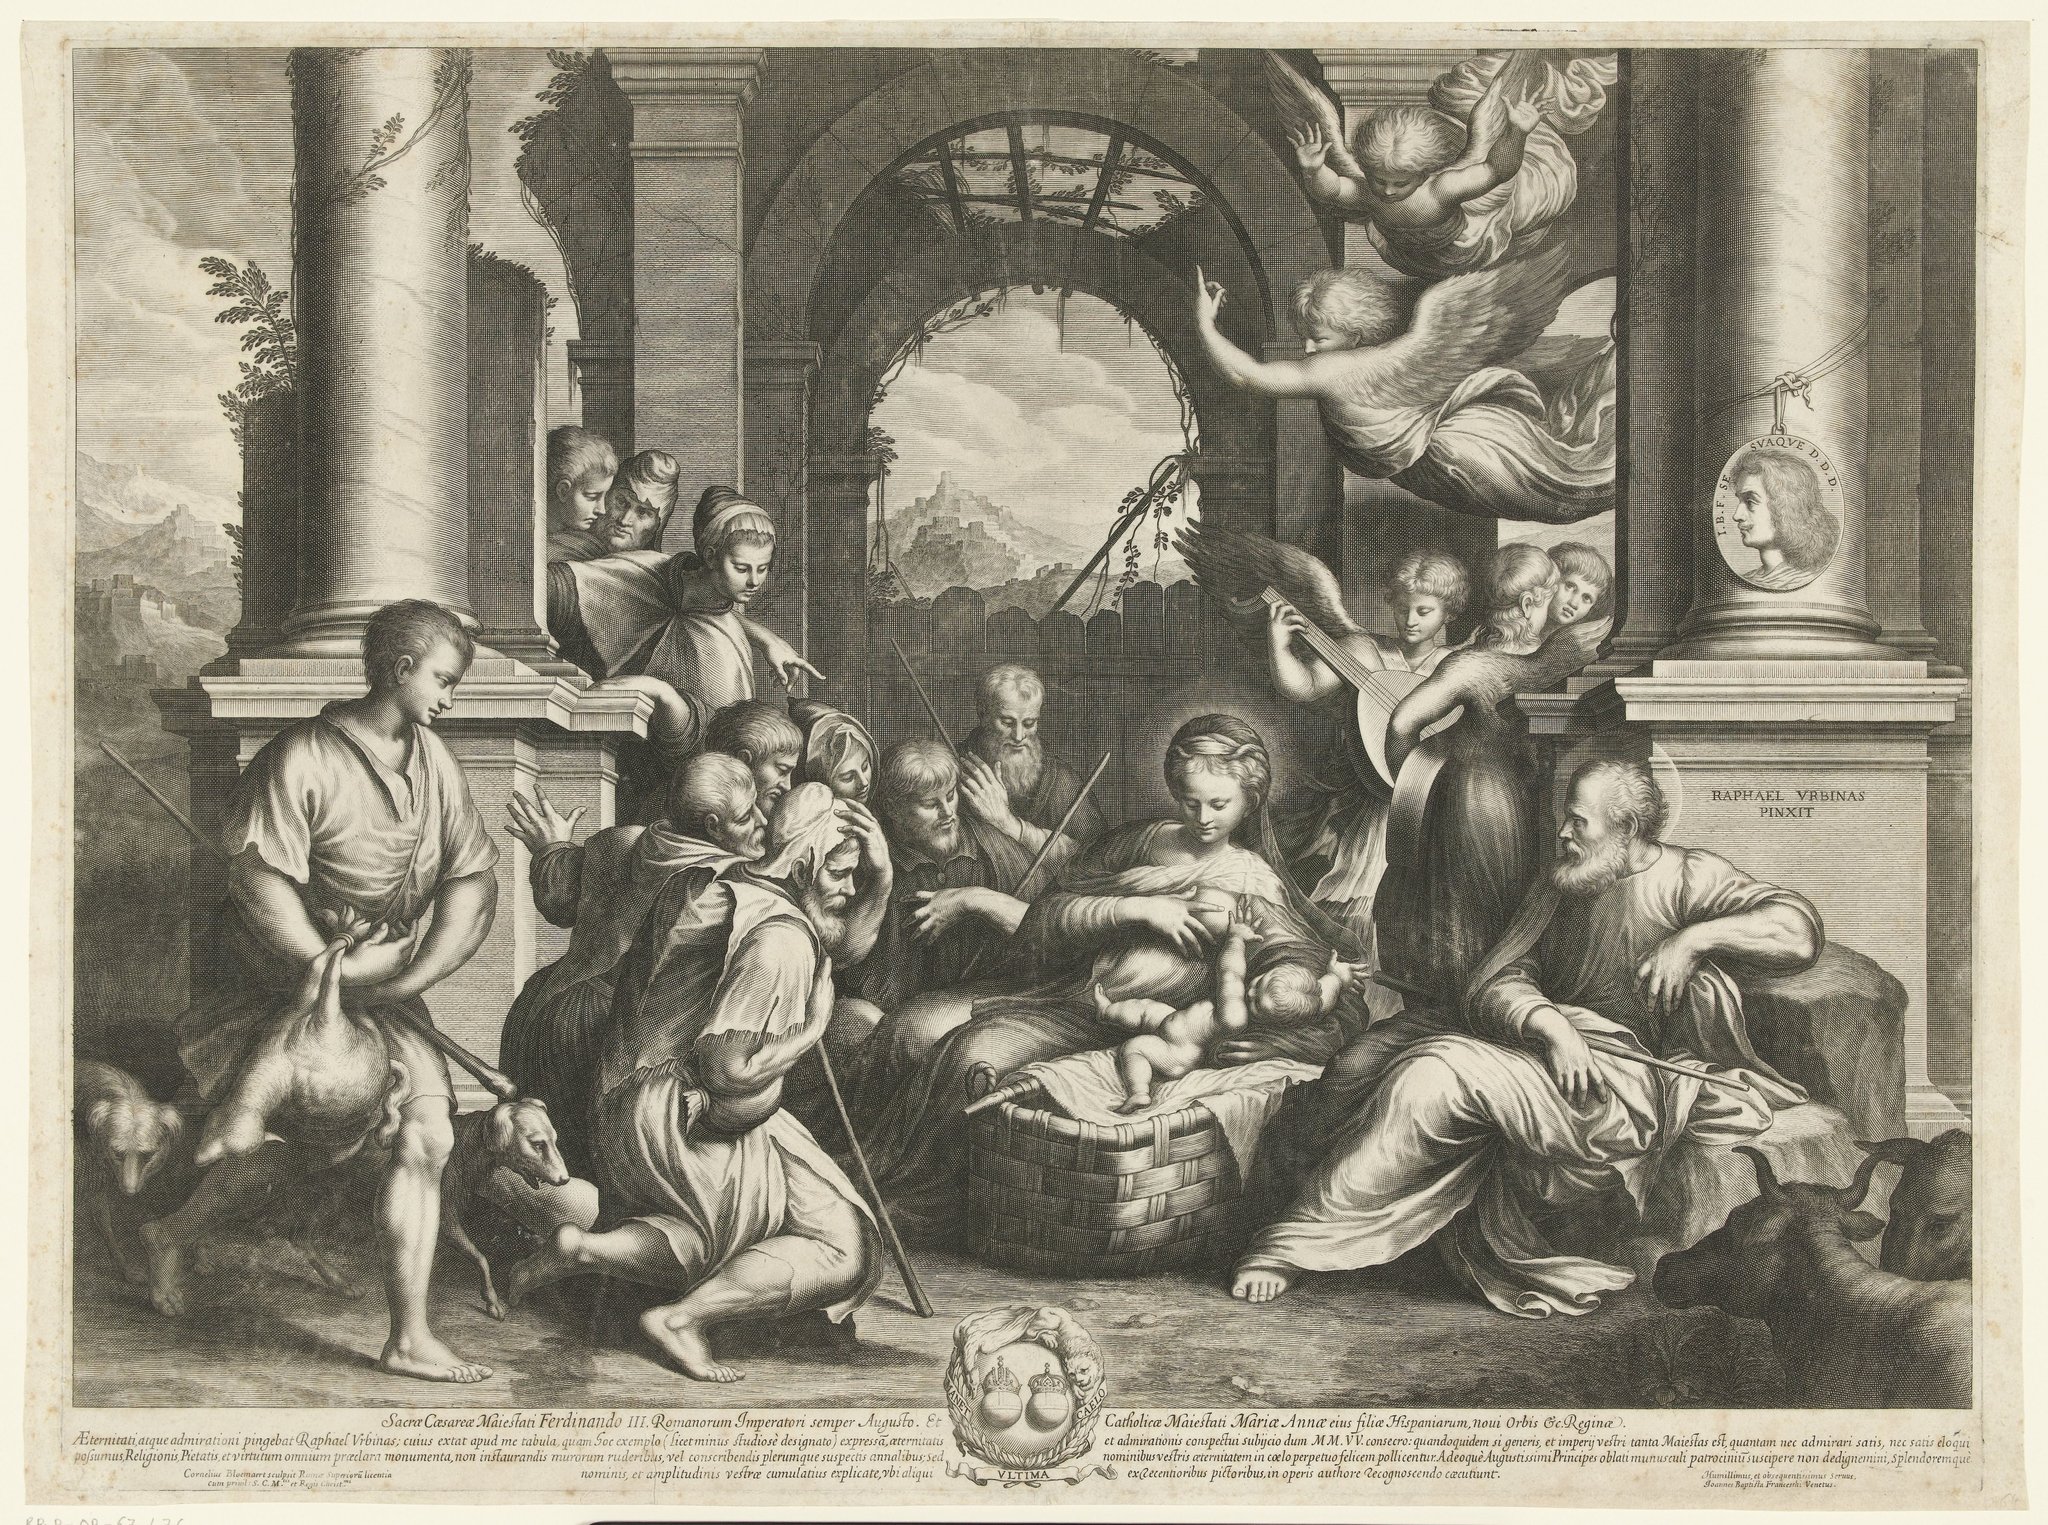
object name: print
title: Aanbidding der herders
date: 1633-1692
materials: paper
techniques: engraving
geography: rome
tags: adoration of the christ-child by the shepherds; mary and joseph present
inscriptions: collector's mark: Lugt 240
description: De herders aanbidden het kind in de stal. Ze knielen voor Maria, Jozef en het kind, een van hen heeft een offerlam meegenomen. In een hoekje van de stal maken engelen muziek op snaarinstrumenten. Jozef zit achterovergeleund tegen een zuil, Maria staat op het punt om het kind de borst te geven.